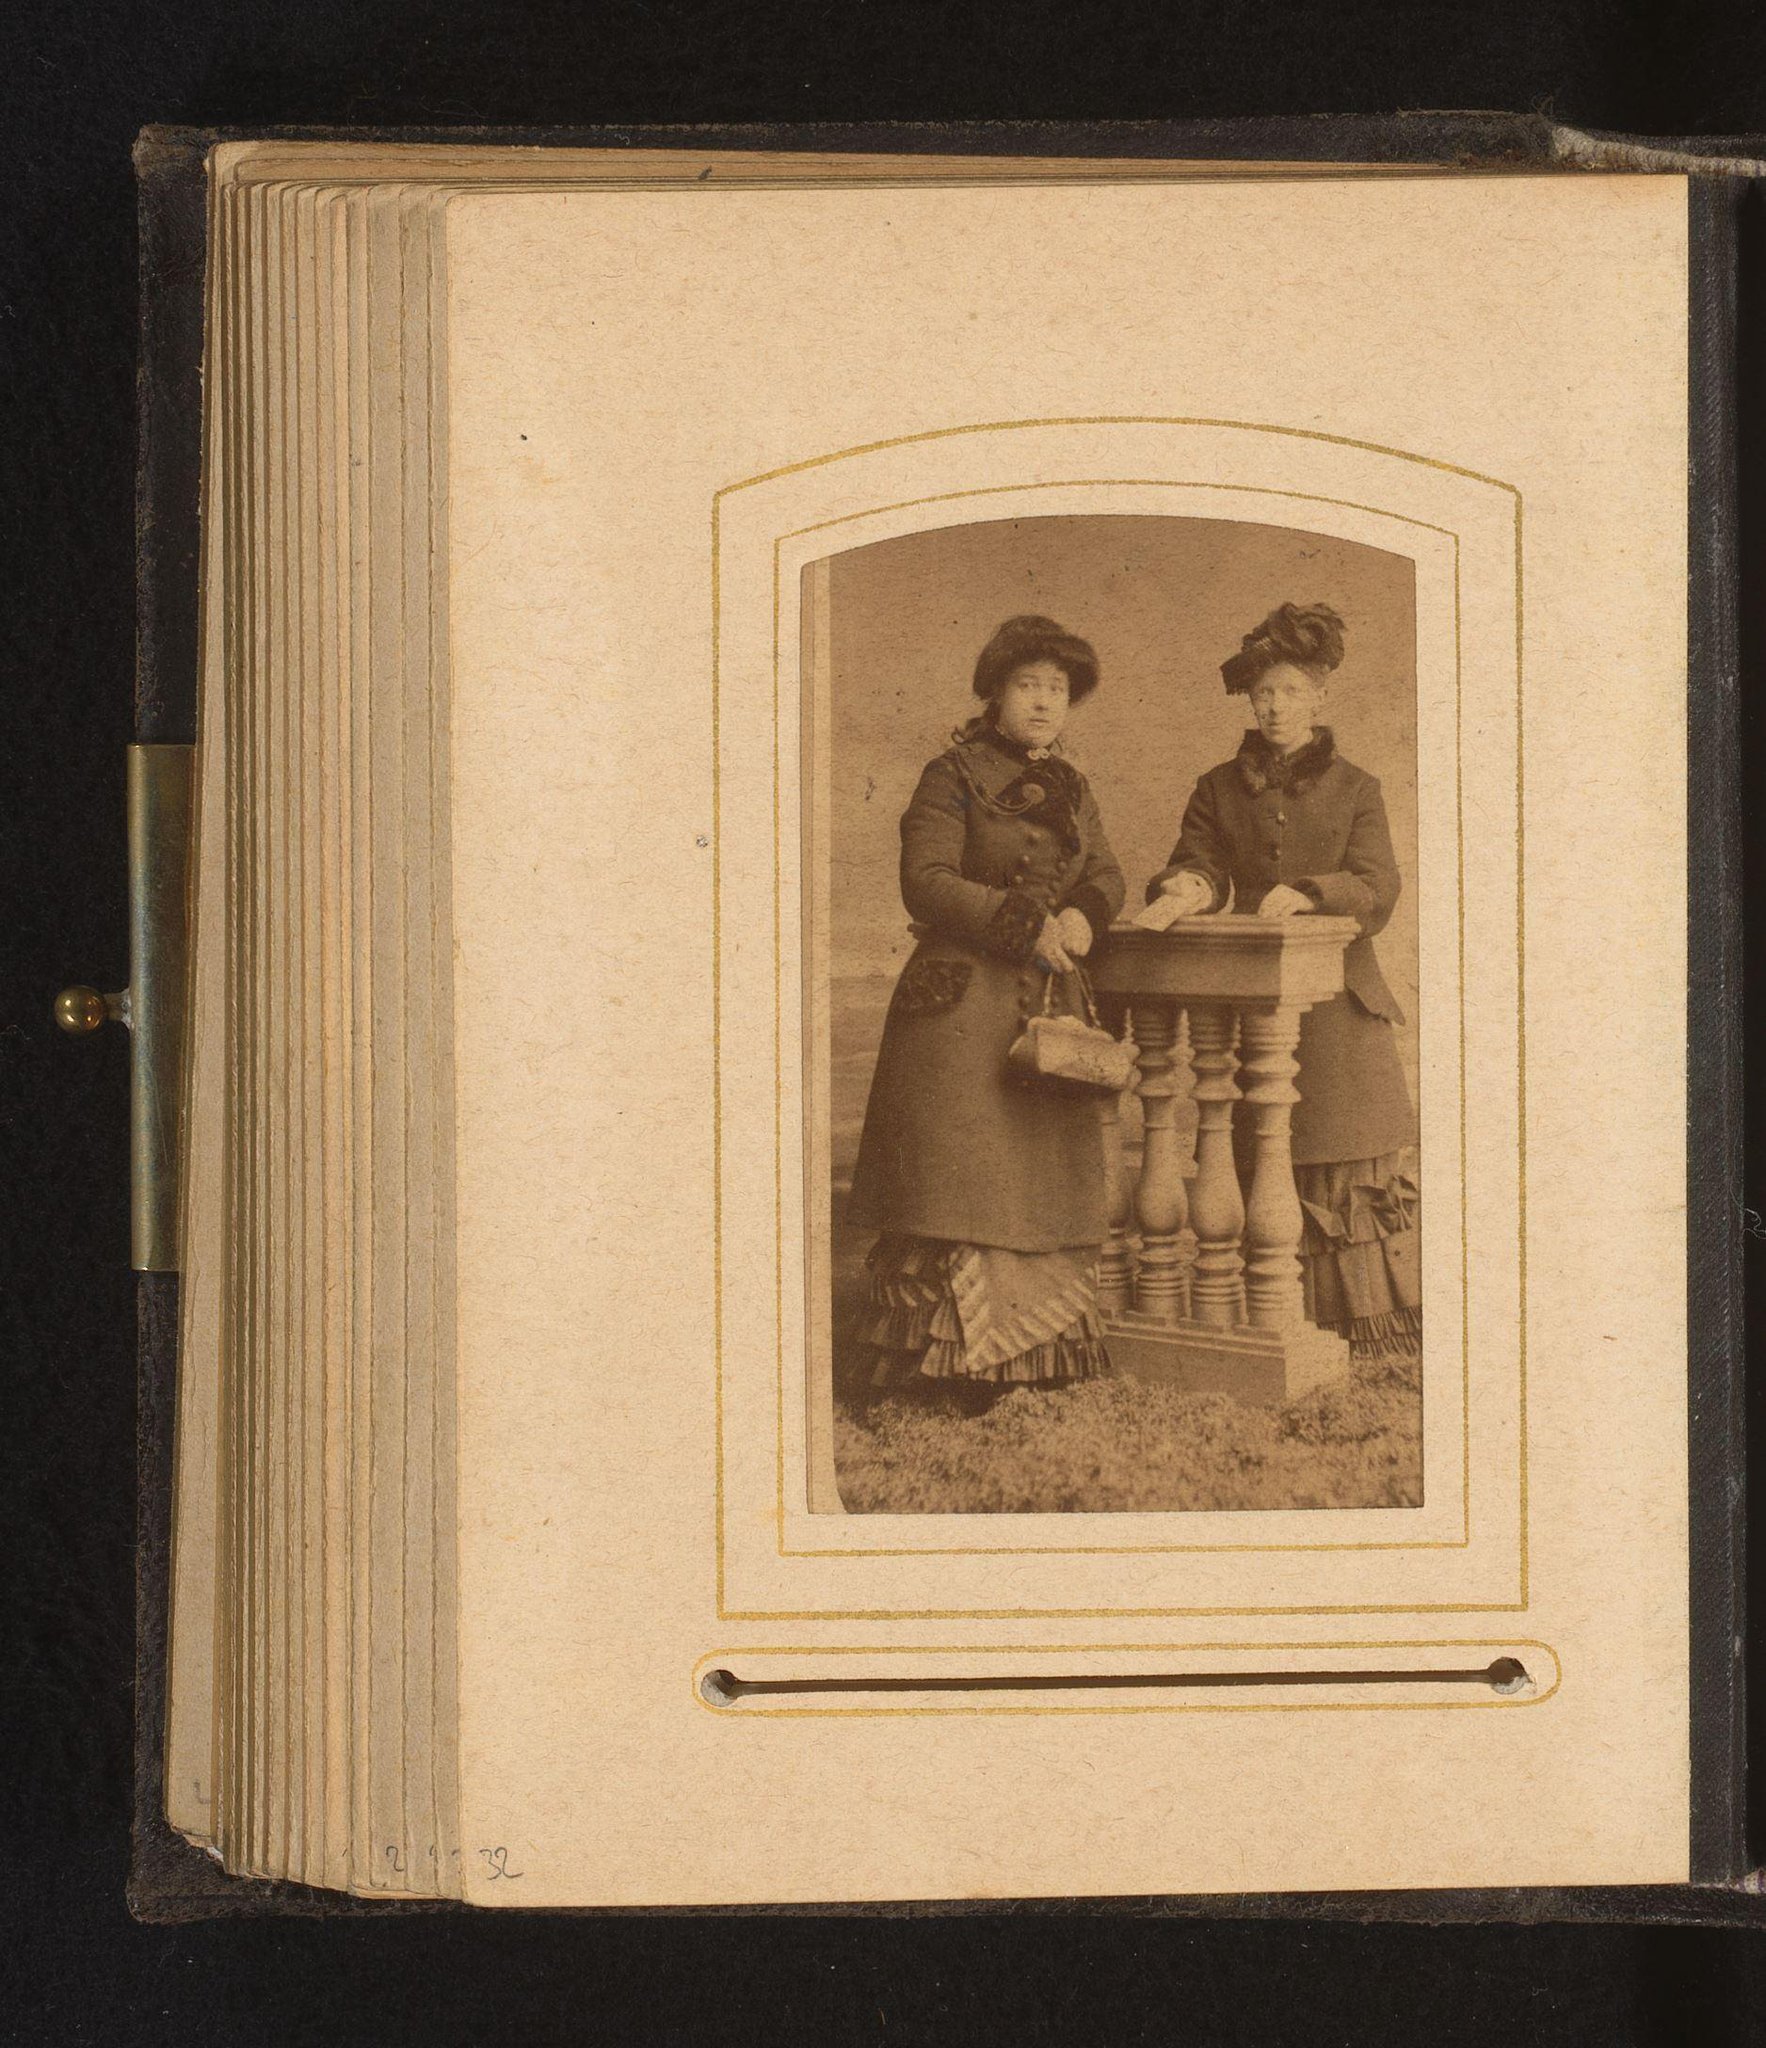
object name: album leaf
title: Portret van twee staande vrouwen met hoeden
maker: thomas johannes kousbroek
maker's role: fotograaf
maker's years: 1858-1900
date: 1882-1895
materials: cardboard, photographic support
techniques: albumen print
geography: leiden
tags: historical persons - bb - woman, head-gear: hat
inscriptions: inscription: ‘T.J. Kousbroek/ Firma H. Harms/ Photographie Instantanée/ Haverzaklaan/ Leiden’